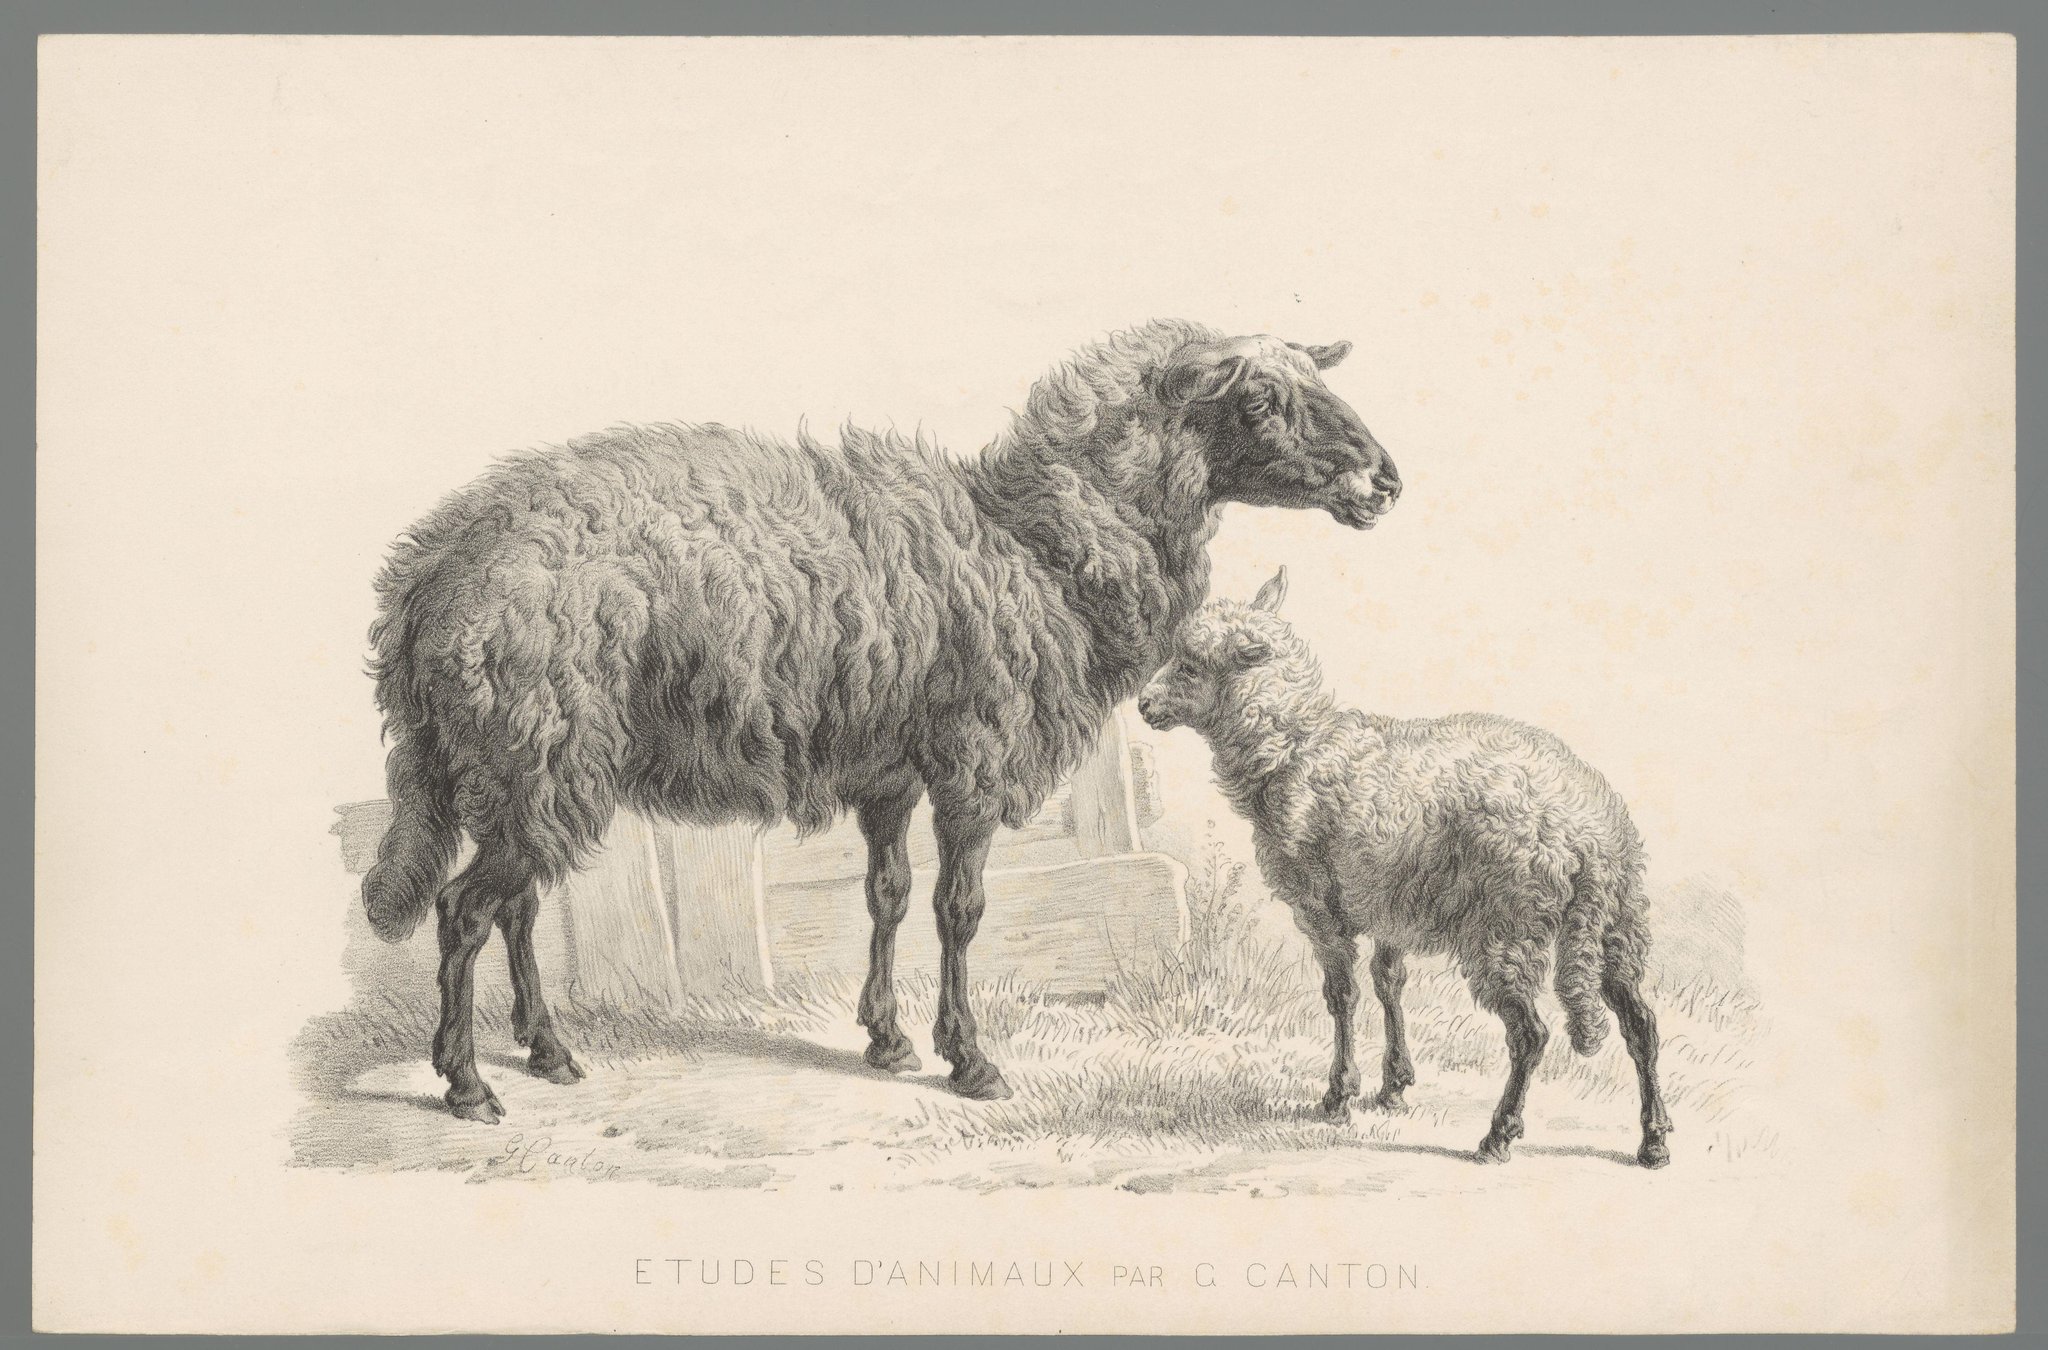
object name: print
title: Schaap met lam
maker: gustav jakob canton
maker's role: print maker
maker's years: 1813-1885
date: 1823-1885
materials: paper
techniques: lithograph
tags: lamb, sheep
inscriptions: collector's mark: Lugt 2228